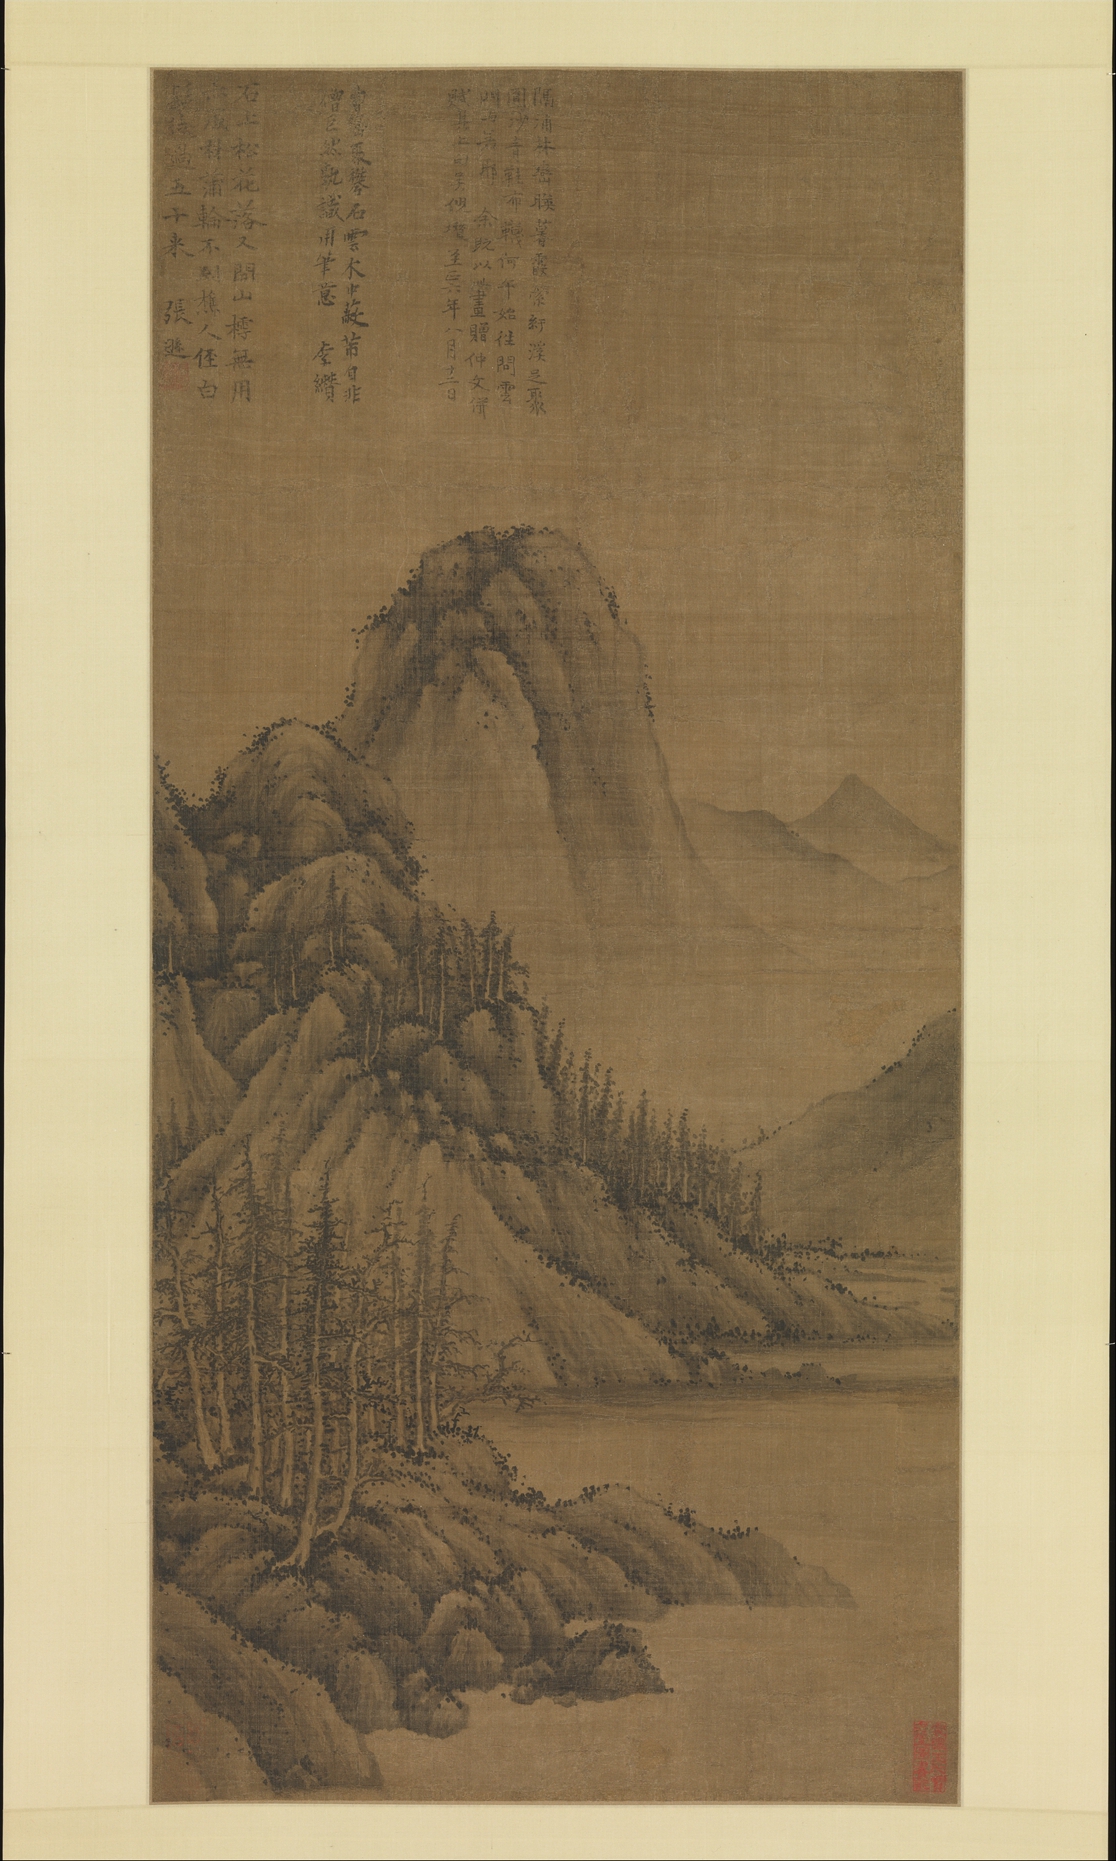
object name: hanging scroll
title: Rocky Landscape with Pines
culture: chinese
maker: zhang xun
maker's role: artist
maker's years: 1295-1349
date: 1346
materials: ink, silk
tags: mountains,landscapes